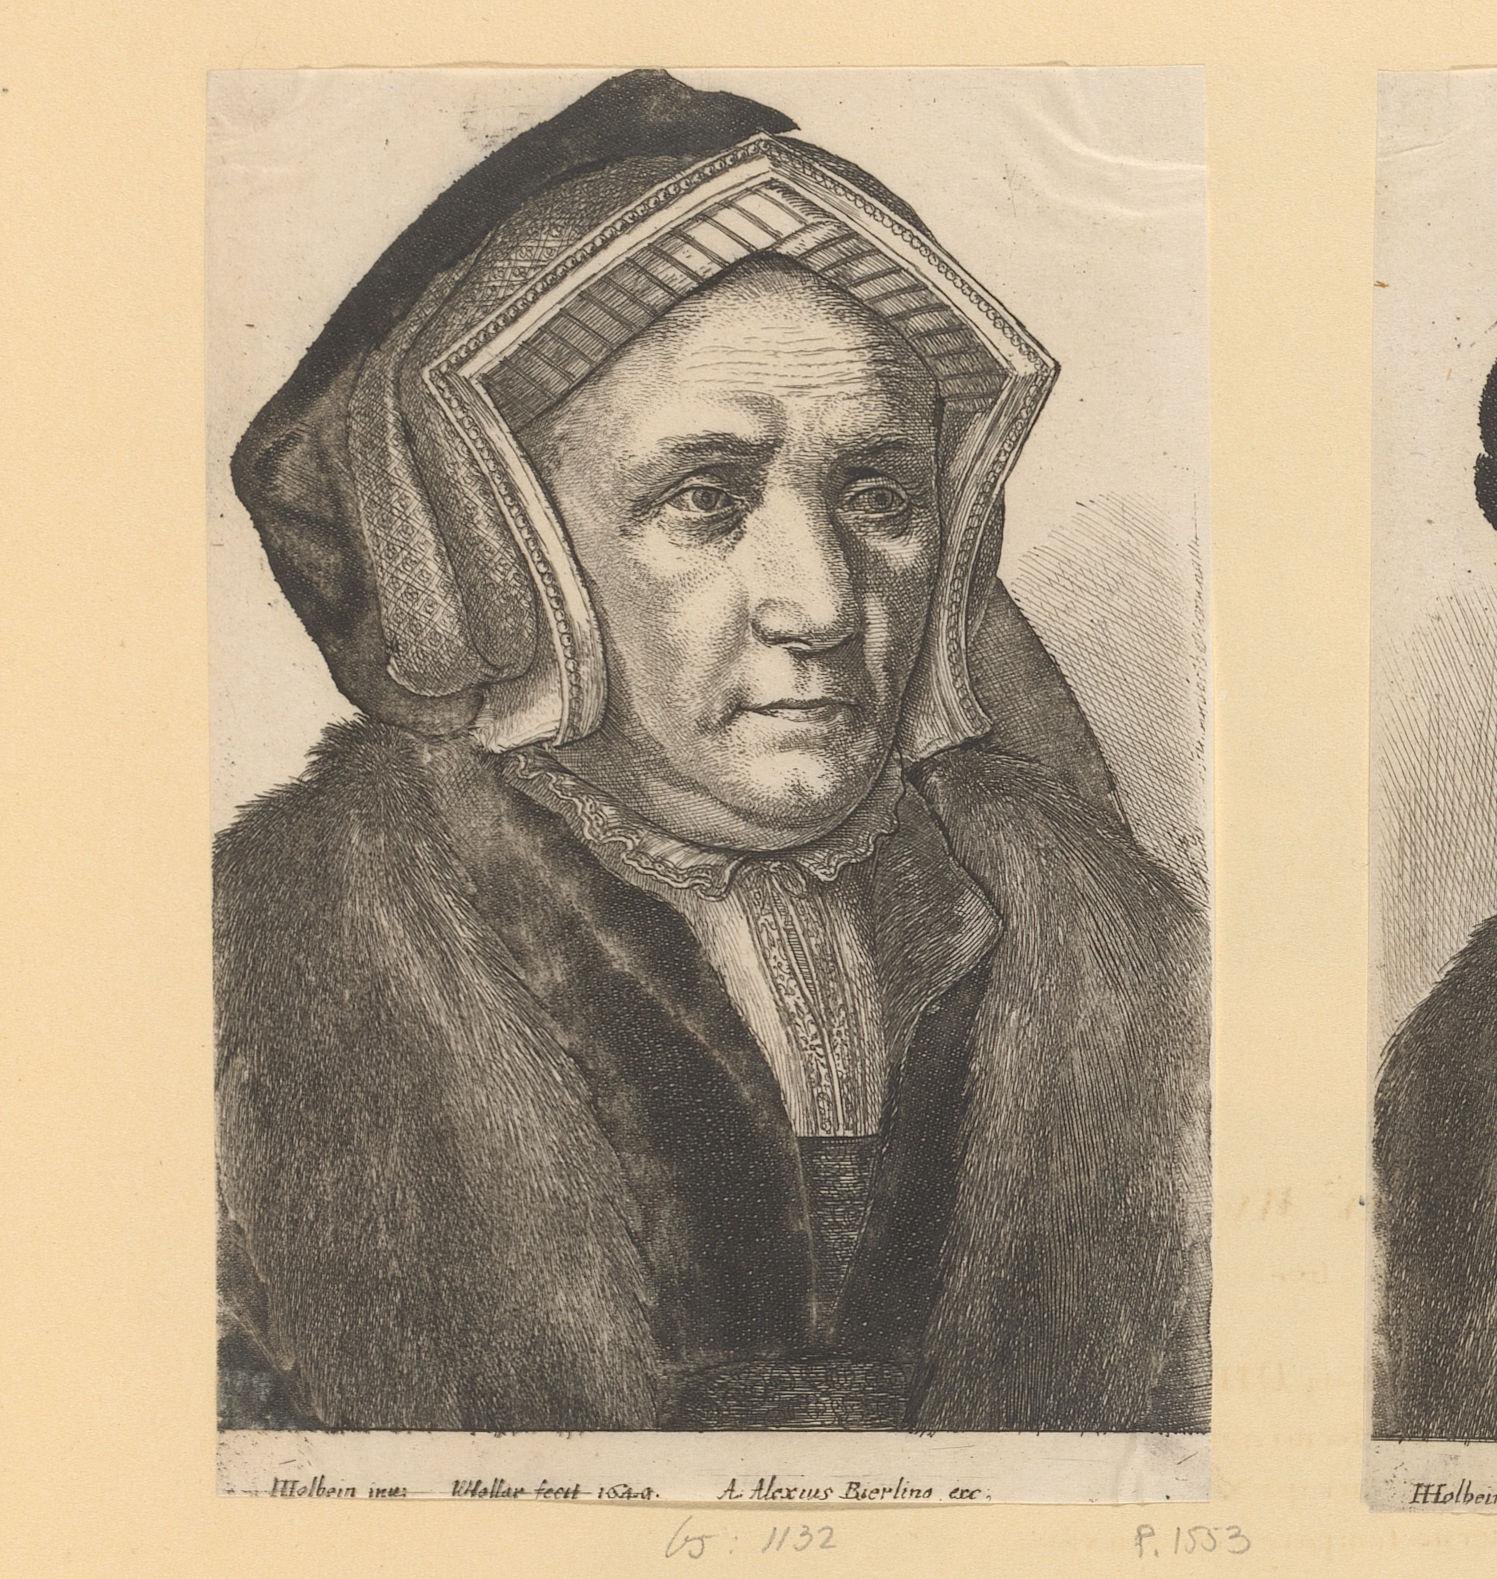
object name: album leaf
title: Portret van Margaret Butts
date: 1649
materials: paper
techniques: etching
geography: antwerp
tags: historical persons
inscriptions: date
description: Prent maakt mogelijk deel uit van een serie van 200 prenten. Deze serie is onder de titel 'A Collection of two hundred original etchings' voor het eerst uitgegeven door J.M. Greery in 1816.